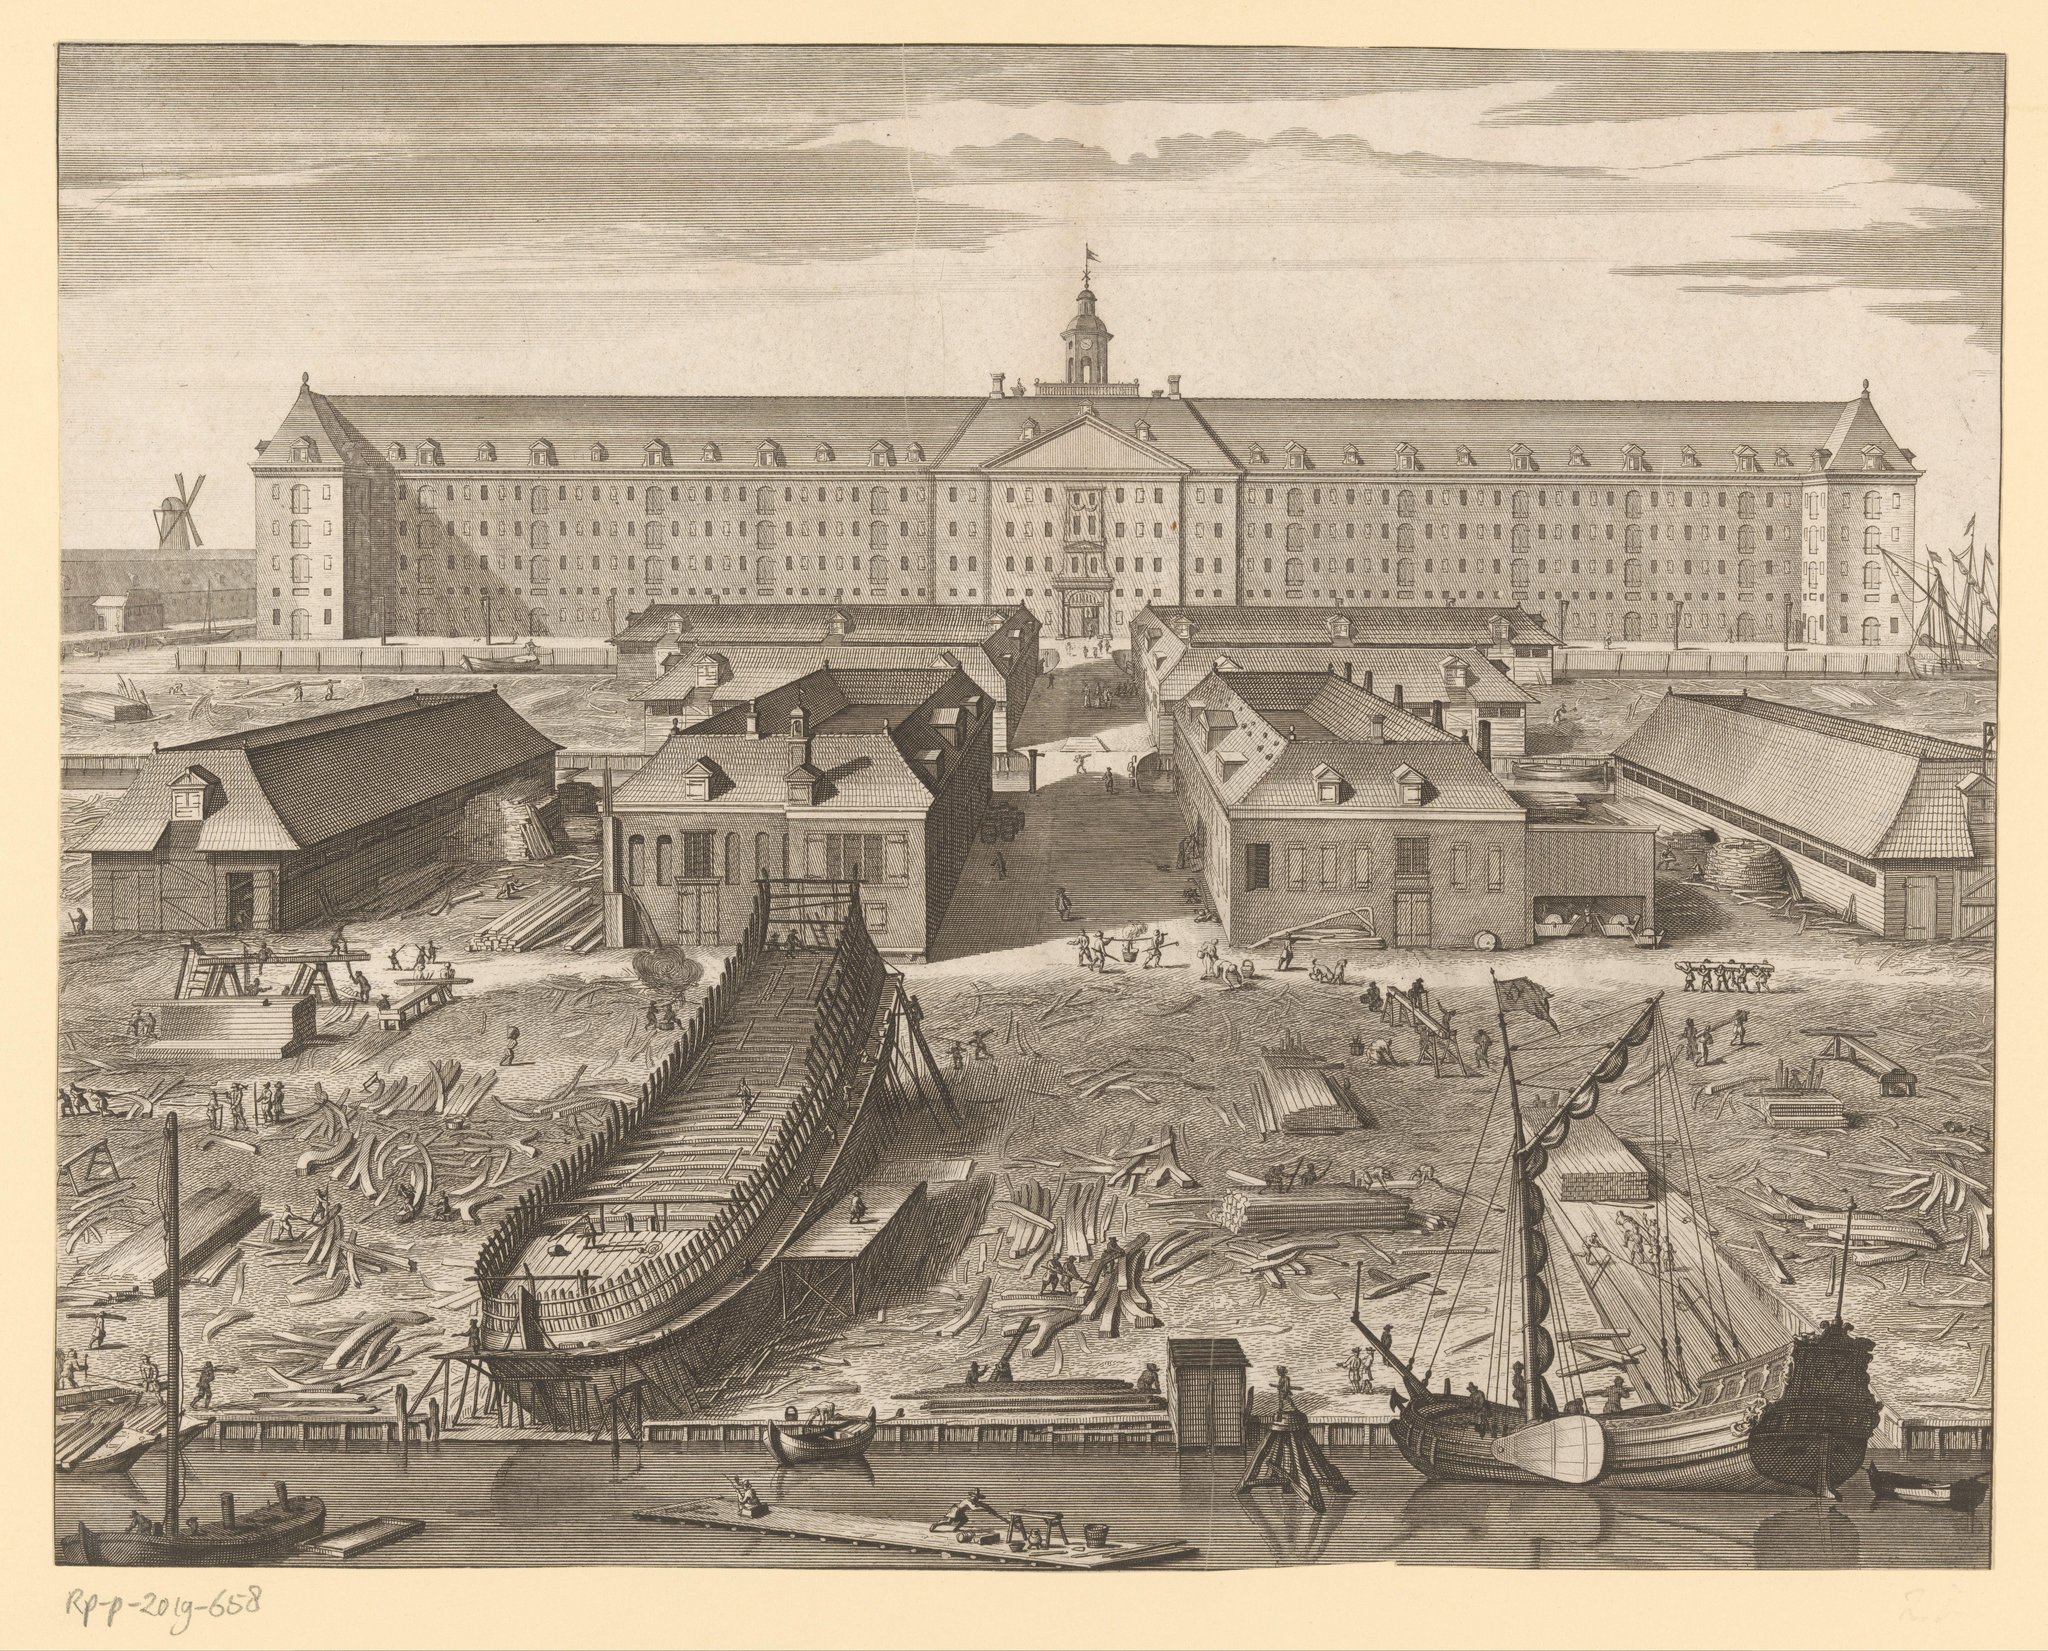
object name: book illustration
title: Gezicht op het Oost-Indisch Zeemagazijn en de scheepstimmerwerf op Oostenburg te Amsterdam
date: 1726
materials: paper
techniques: engraving, etching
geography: amsterdam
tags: warehouse (~ harbour), shipyard, shipdock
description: Prent uit: Commelin, Caspar. Beschryvinge van Amsterdam, zynde een naukeruige verhandelinge van desselfs eerste oorspronk uyt den Huyse (…). Amsterdam: Andries van Damme et al., 1726, tussen p. 734 en 735.